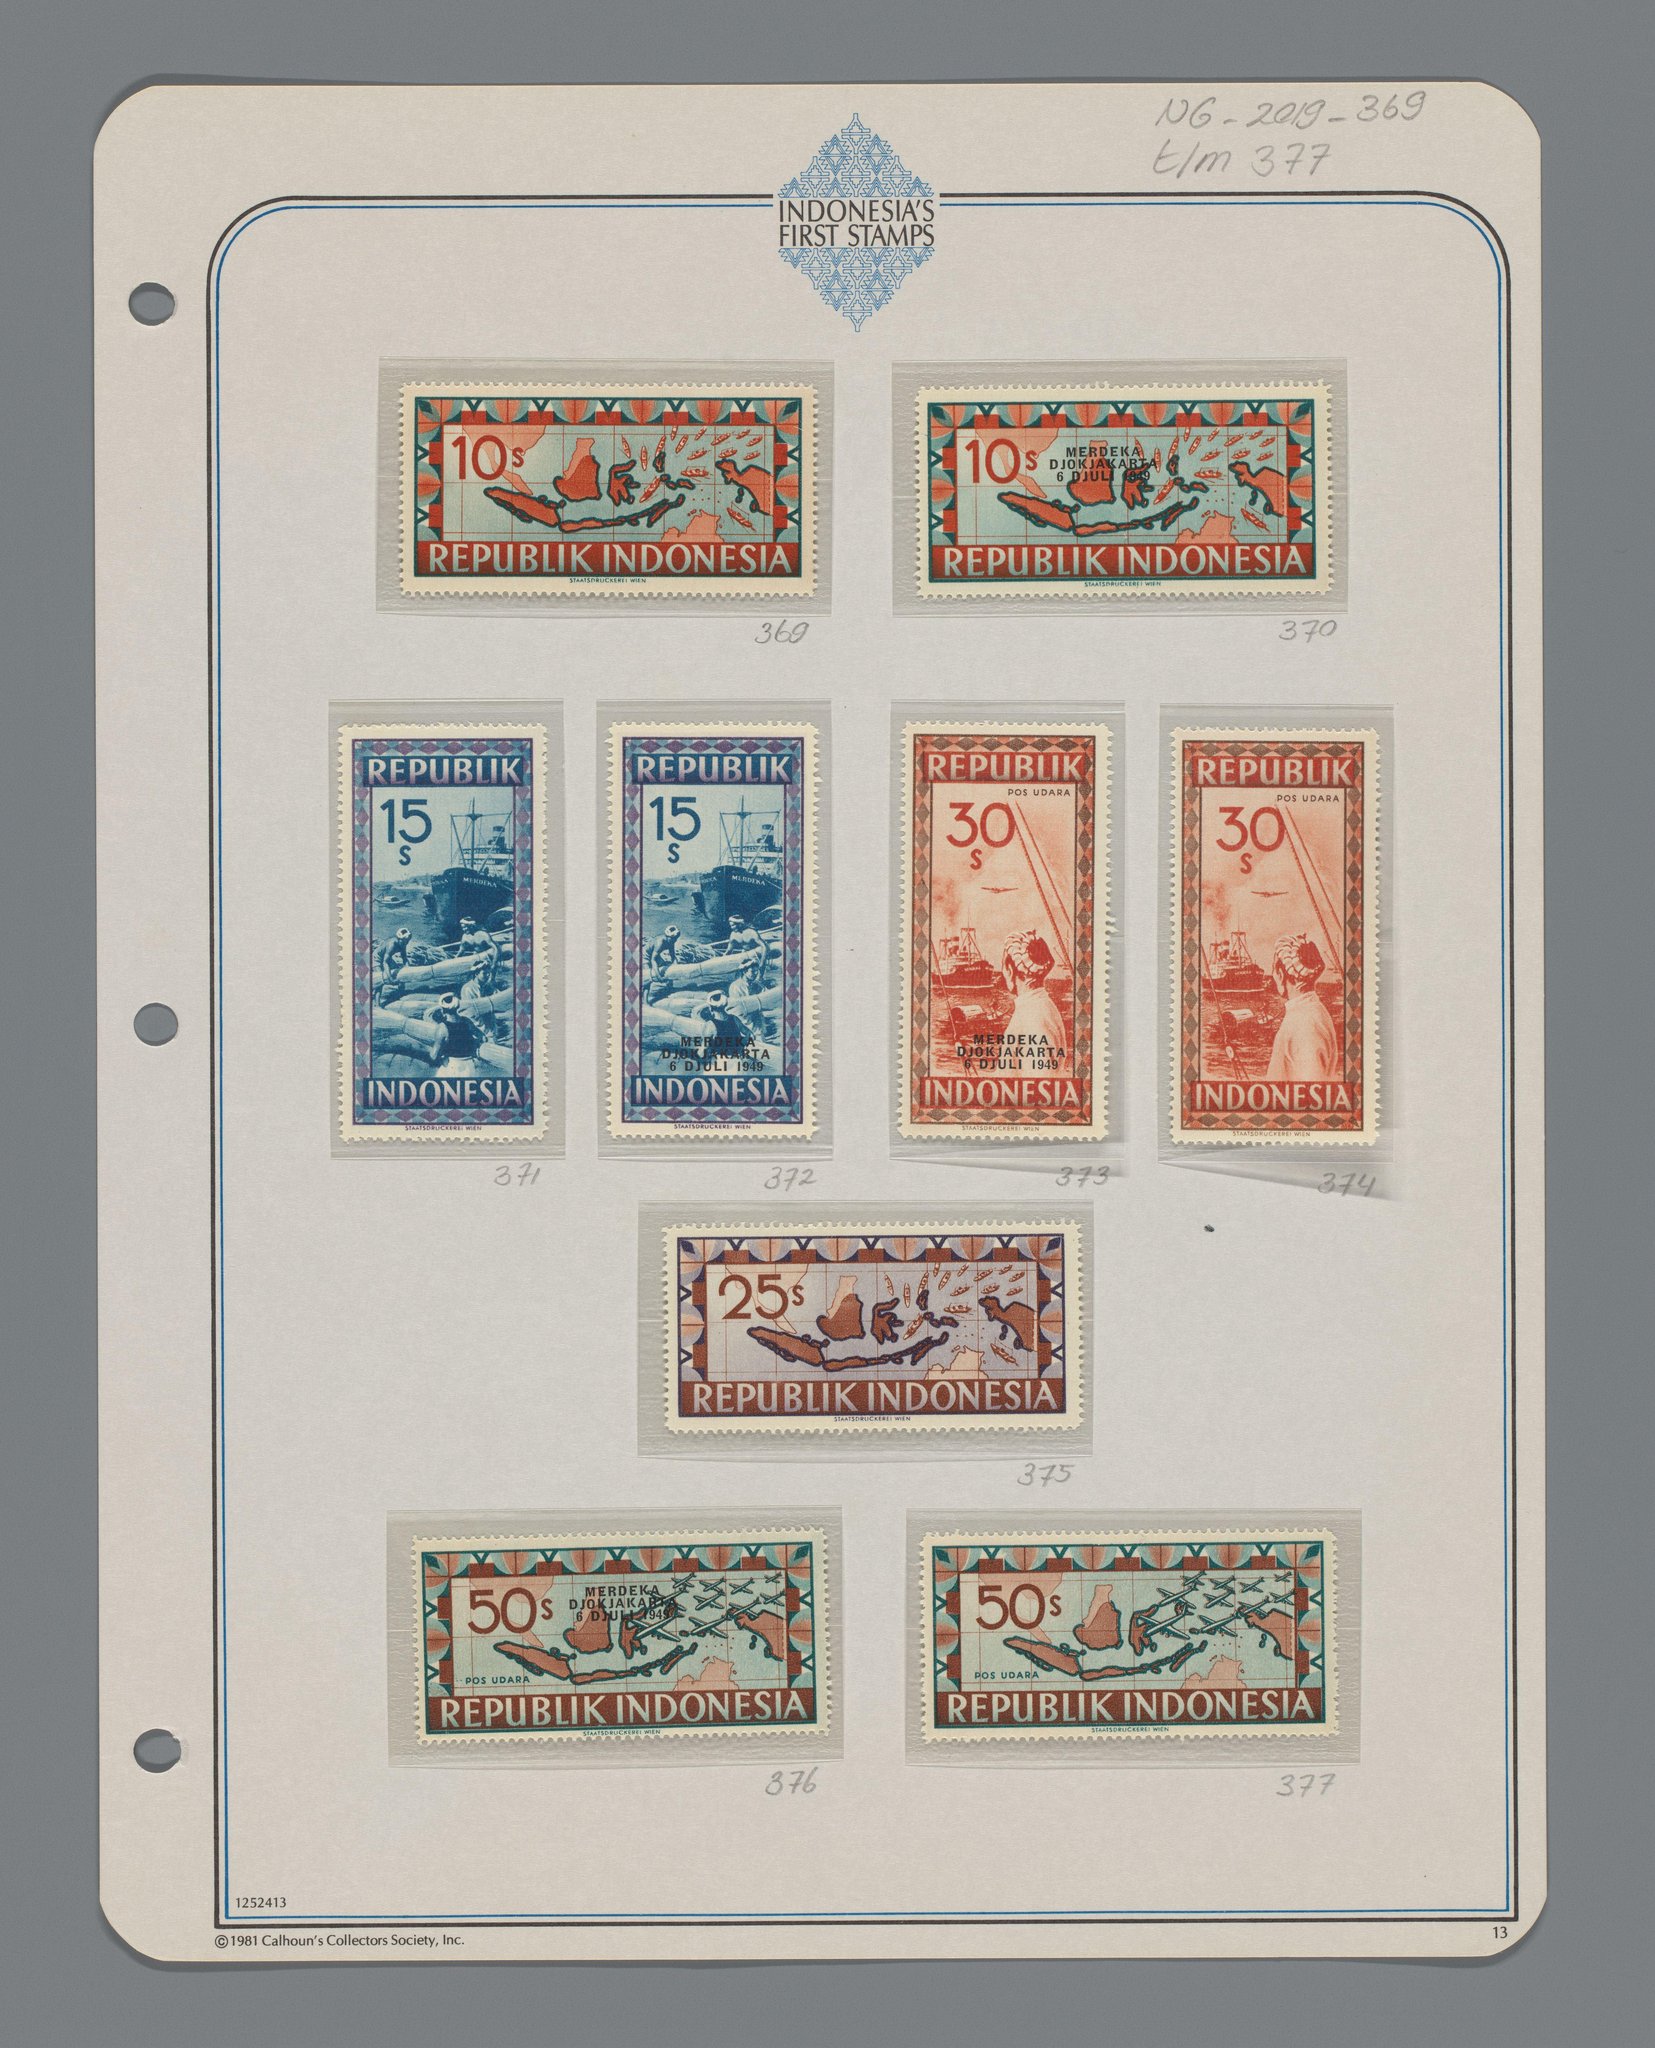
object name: postage stamp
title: Postzegel Republik Indonesia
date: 1949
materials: paper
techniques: photoaquatint, engraving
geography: philadelphia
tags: indonesia